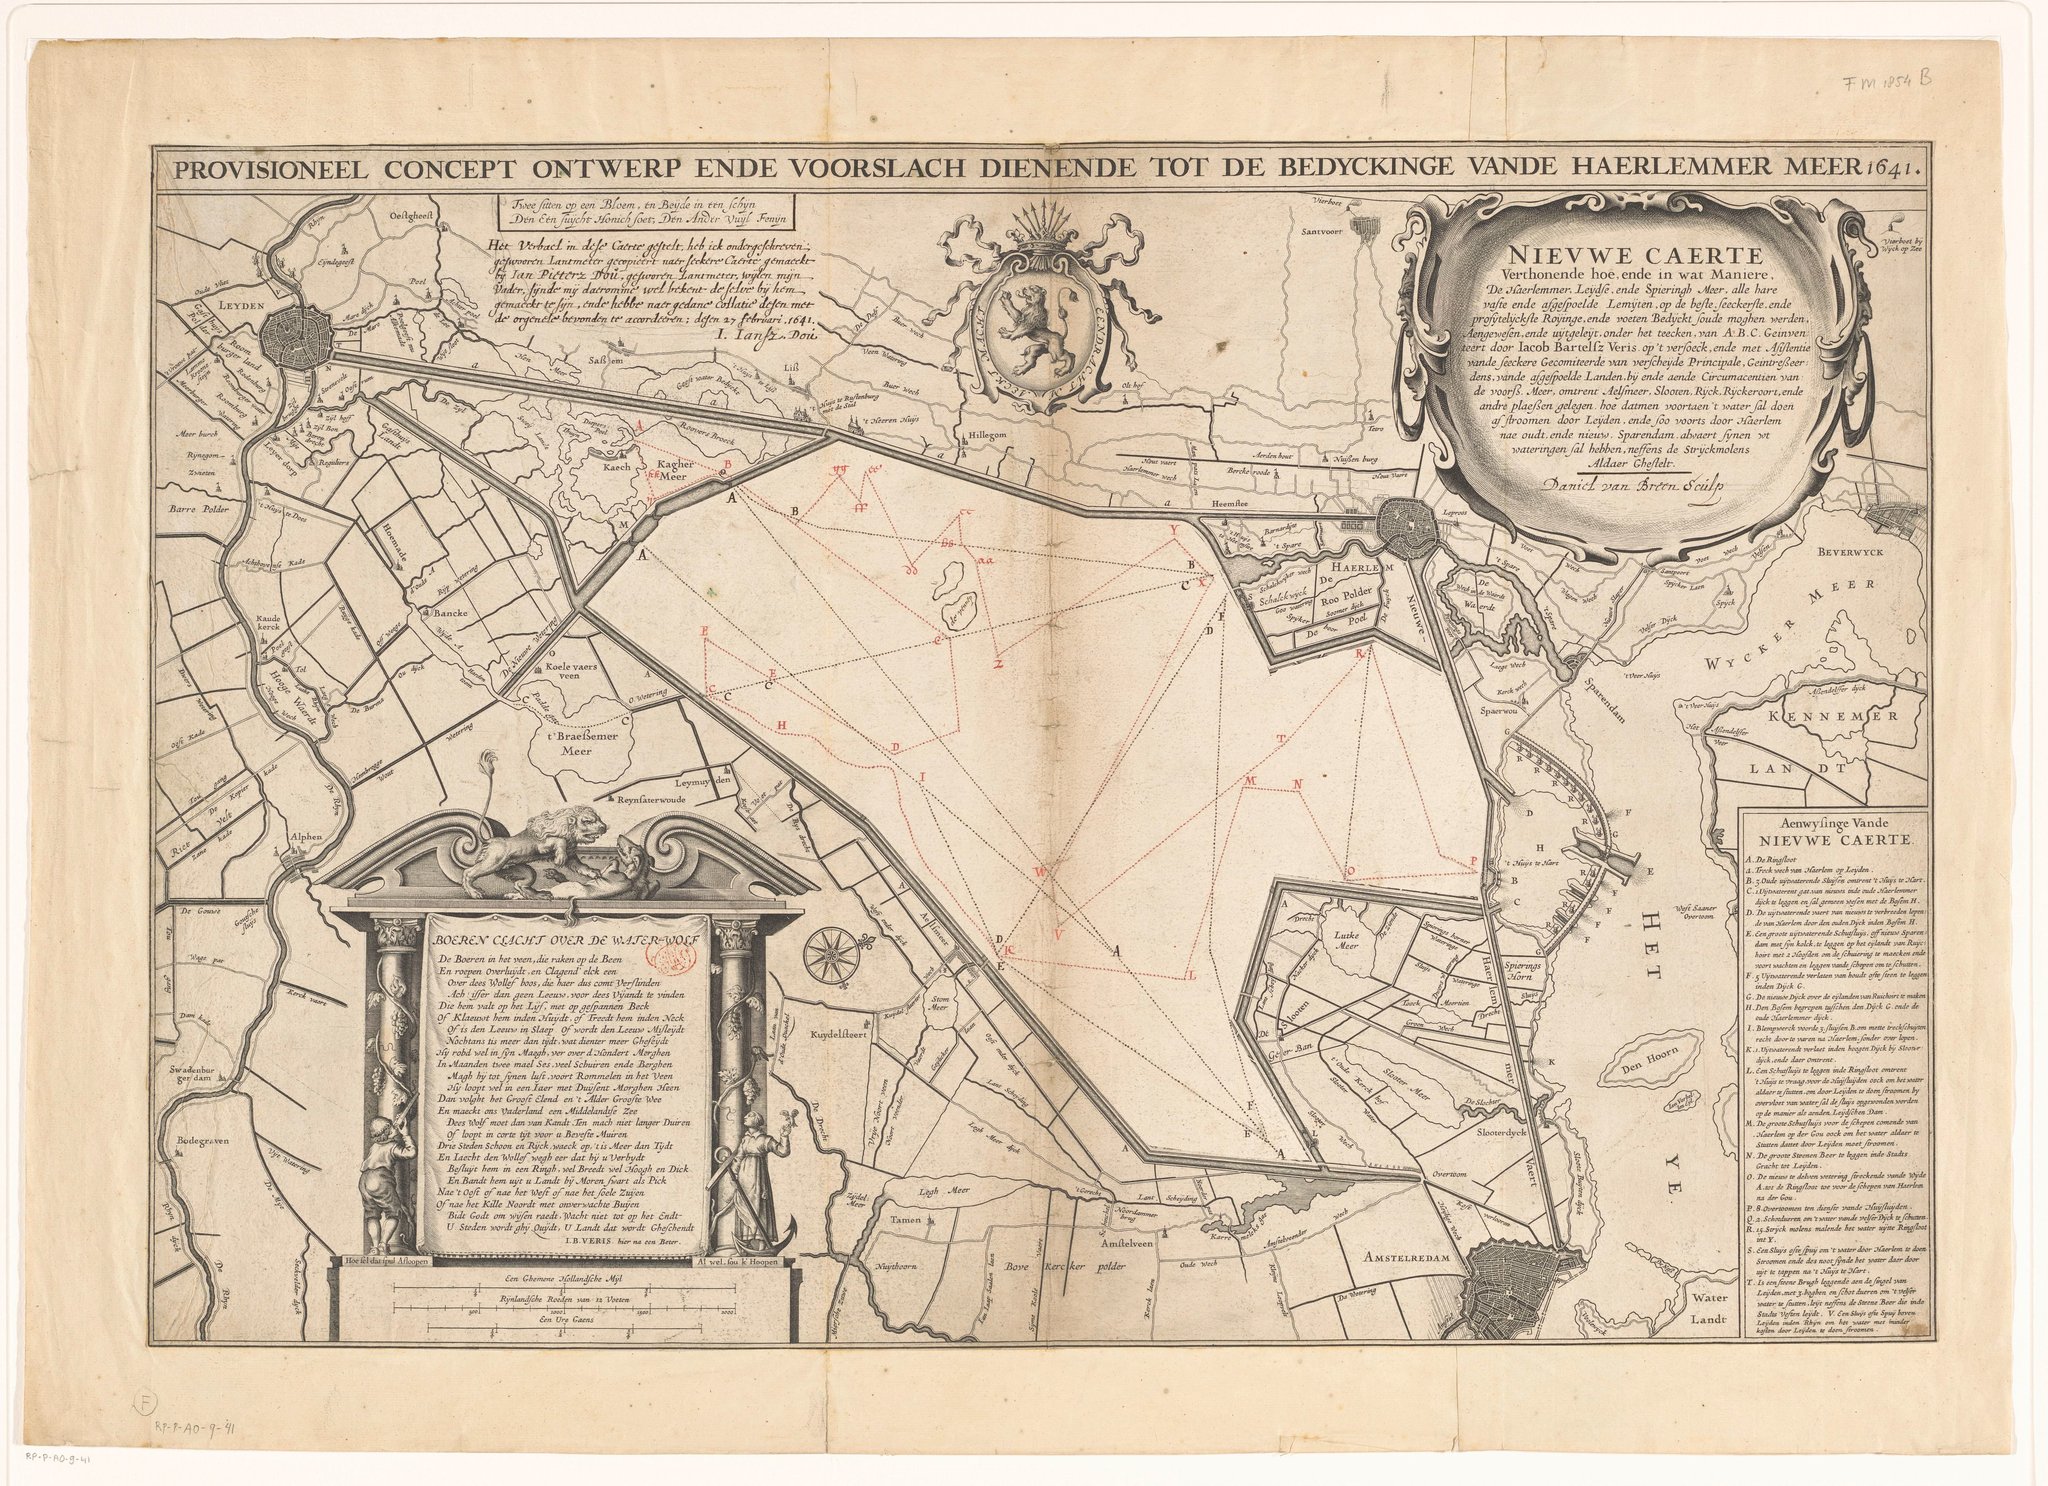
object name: print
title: Provisioneel concept ontwerp ende voorslach dienende tot de bedyckinge vande Haerlemmer Meer 1641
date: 1641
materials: ink, paper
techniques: engraving, etching, pen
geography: northern netherlands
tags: coat of arms (as symbol of the state, etc.), maps of separate countries or regions, polder, reclaimed land, maps of cities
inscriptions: collector's mark: Lugt 2228, collector's mark: Lugt 195, signature: ‘Daniel van Breen sculp’, inscription: ‘Het Verbael in dese Caerte gestelt, heb ick ondergeschreven; / geswooren Lantmeter gecopieert naer seckere Caerte gemaeckt / bij Ian Pietersz Dou, gesworen Lantmeter, wijlen mijn / Vader, sijnde mij daeromme wel bekent deselve bij hem / gemaeckt te sijn, ende hebbe naer gedane collatie desen met / de orgenele bevonden te accordeeren; desen 27 februari, 1641. / I. Jansz. Dou’, inscription:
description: Mogelijk kopie naar de prent van Willem van der Laegh, zie RP-P-OB-81.622 en RP-P-AO-9-42. Zie ook RP-P-1939-1451.